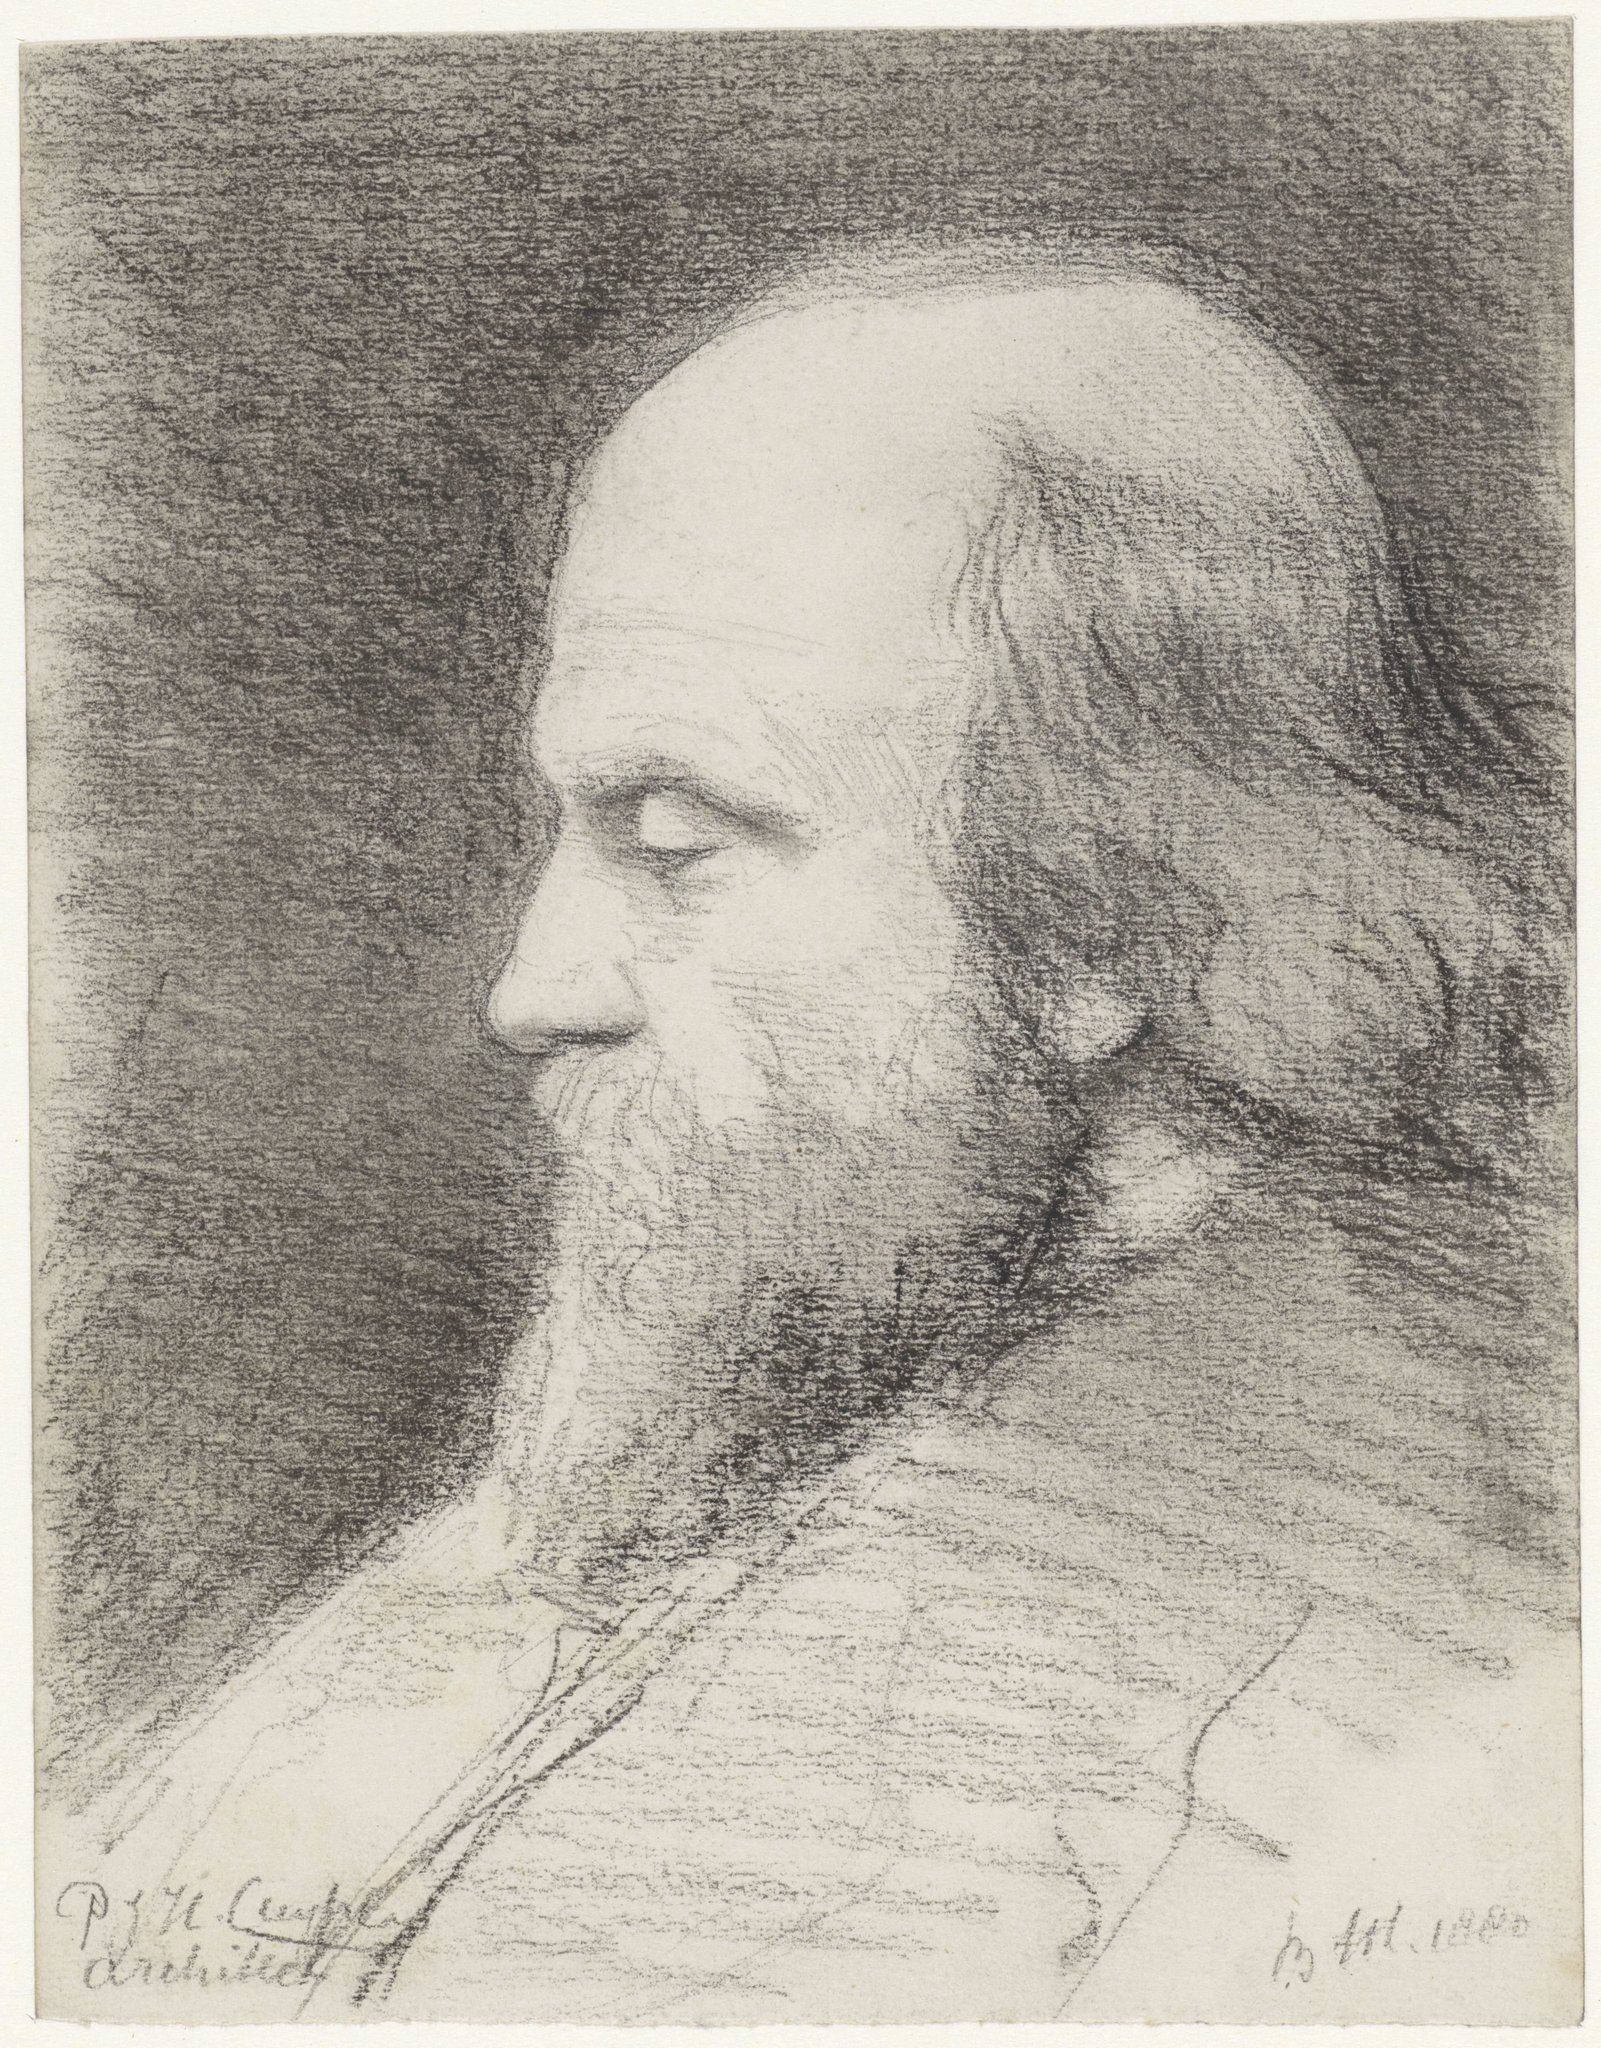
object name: drawing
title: Portret van P.J.H. Cuypers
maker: a.a.l. de grammont-hubrecht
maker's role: draughtsman, painter, print maker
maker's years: 1855-1913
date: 1880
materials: chalk, paper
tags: pierre joseph hubert cuypers, historical persons, portrait, self-portrait of architect